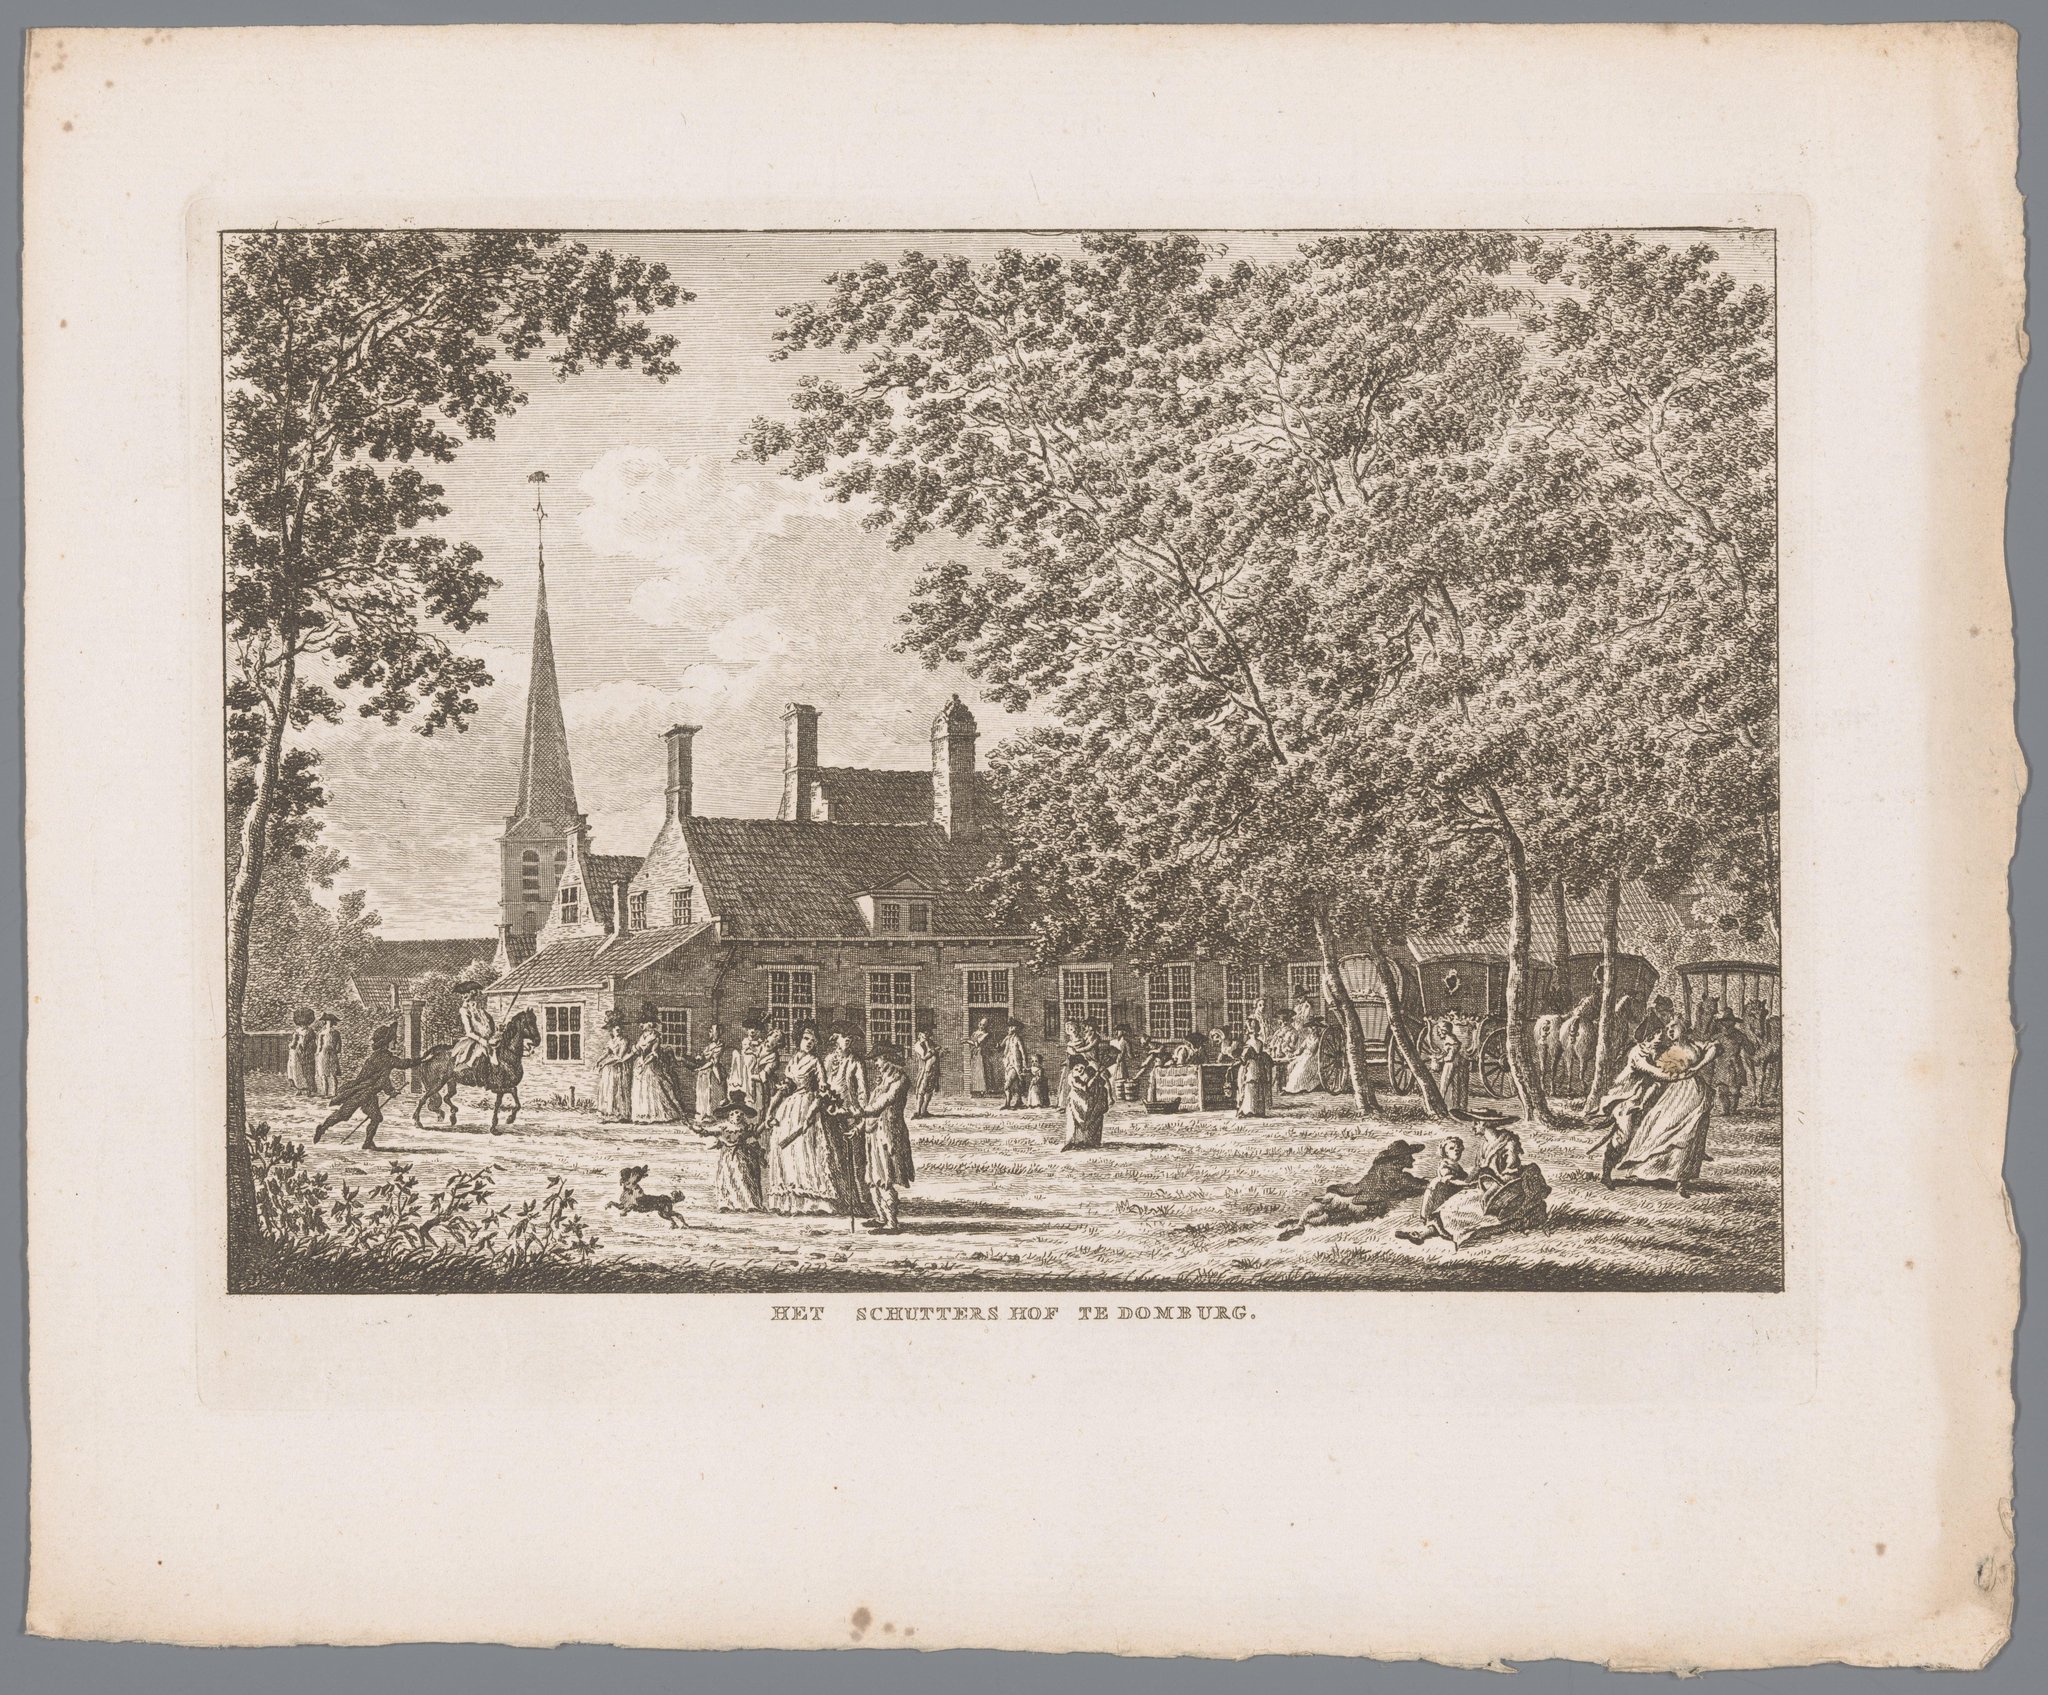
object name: print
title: Gezicht op het Schuttershof in Domburg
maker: carel frederik bendorp (i)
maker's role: print maker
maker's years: 1736-1814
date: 1786-1792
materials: paper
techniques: etching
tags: courtyard, village square, place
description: Prent uit: Vaderlandsche gezichten, of afbeeldingen van den tegenwoordigen staat der Vereenigde Nederlanden (…). Amsterdam: Hendrik Gartman, Willem Vermandel en Jan Willem Smit, 1786-1792. Uitgegeven in afleveringen met ieder een eigen bifolium en inhoudsopgave. Alle prenten in deze publicatie zijn gegraveerd door Carel Frederik Bendorp (I) en, in de meeste gevallen, gebaseerd op tekeningen van Jan Bulthuis.